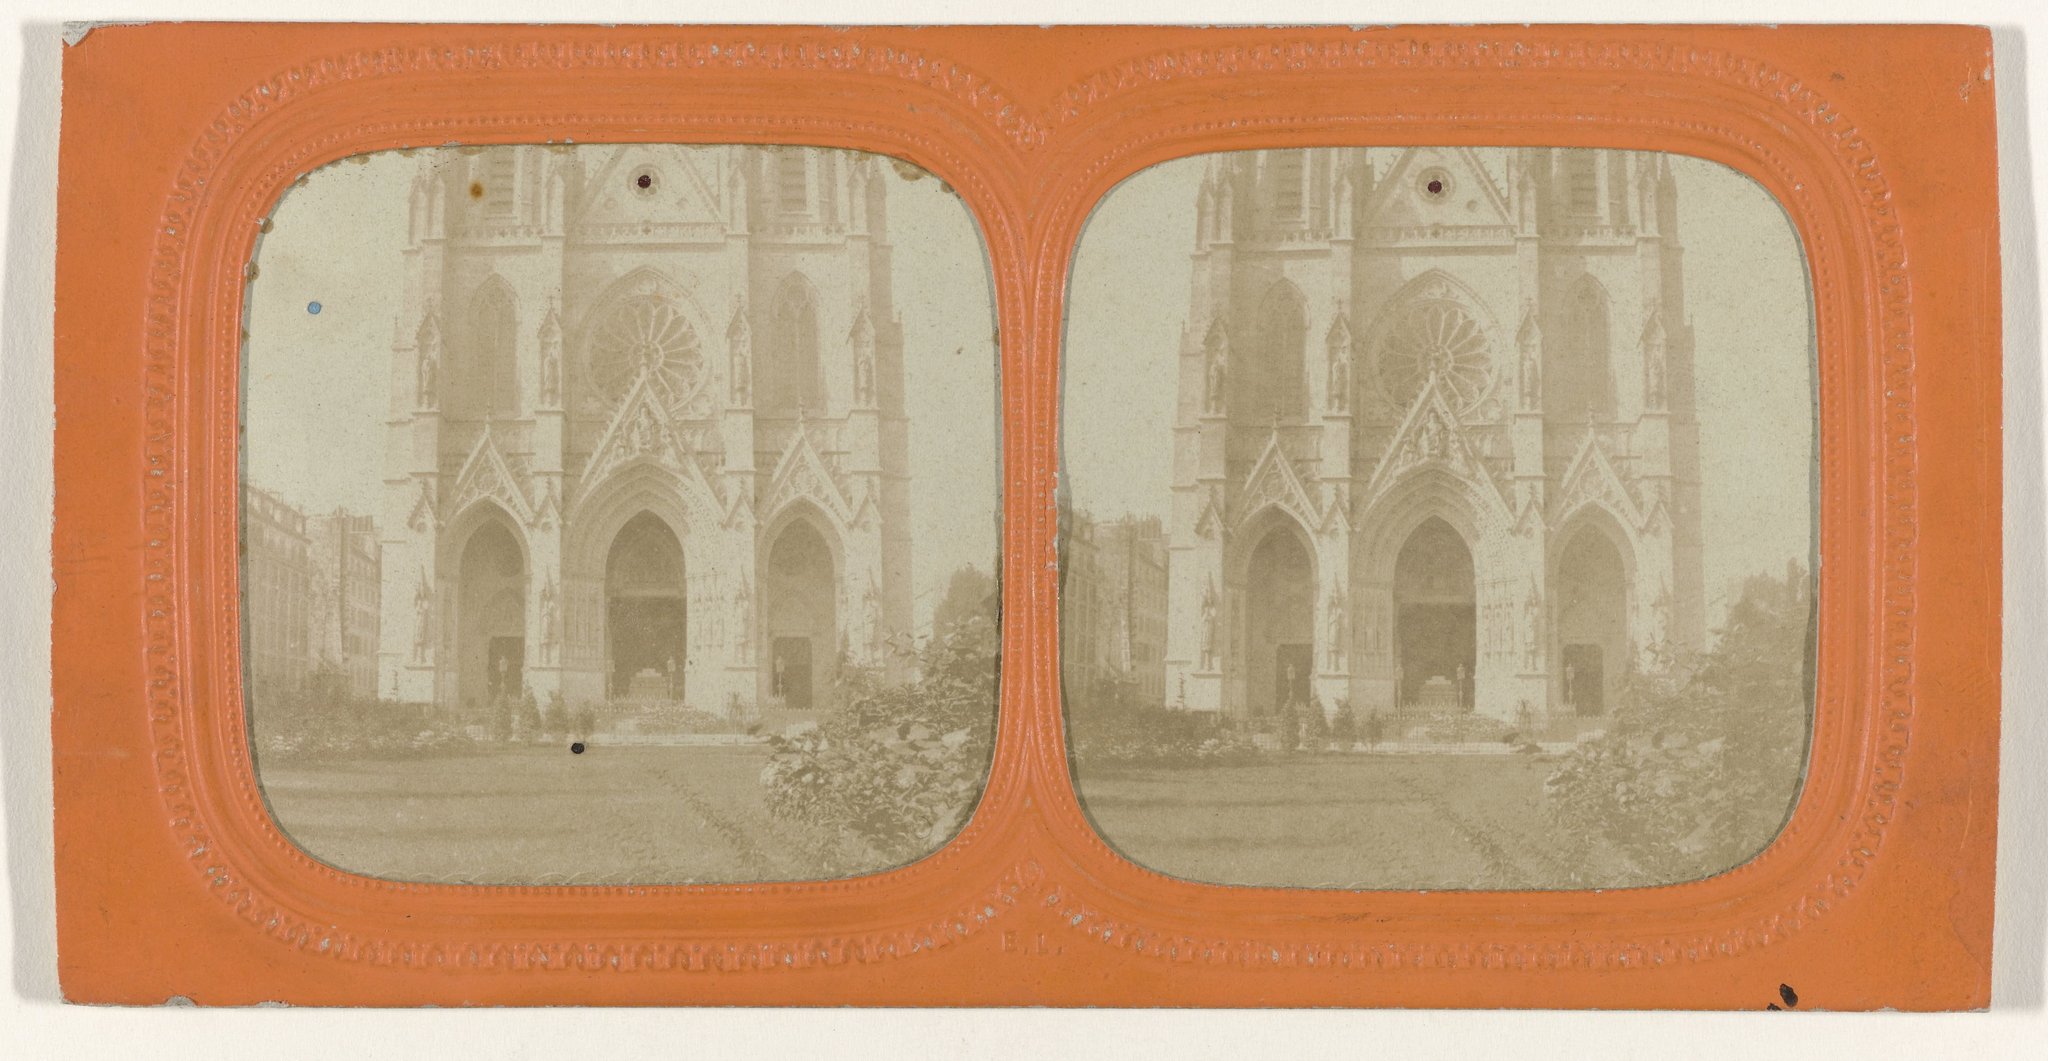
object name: stereograph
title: Portaal van de Église Sante-Clotilde in Parijs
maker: Anonymous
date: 1855-1875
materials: cardboard, paper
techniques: albumen print, cutting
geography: paris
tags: parts of church exterior and annexes: portal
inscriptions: monogram: ‘E.L.’